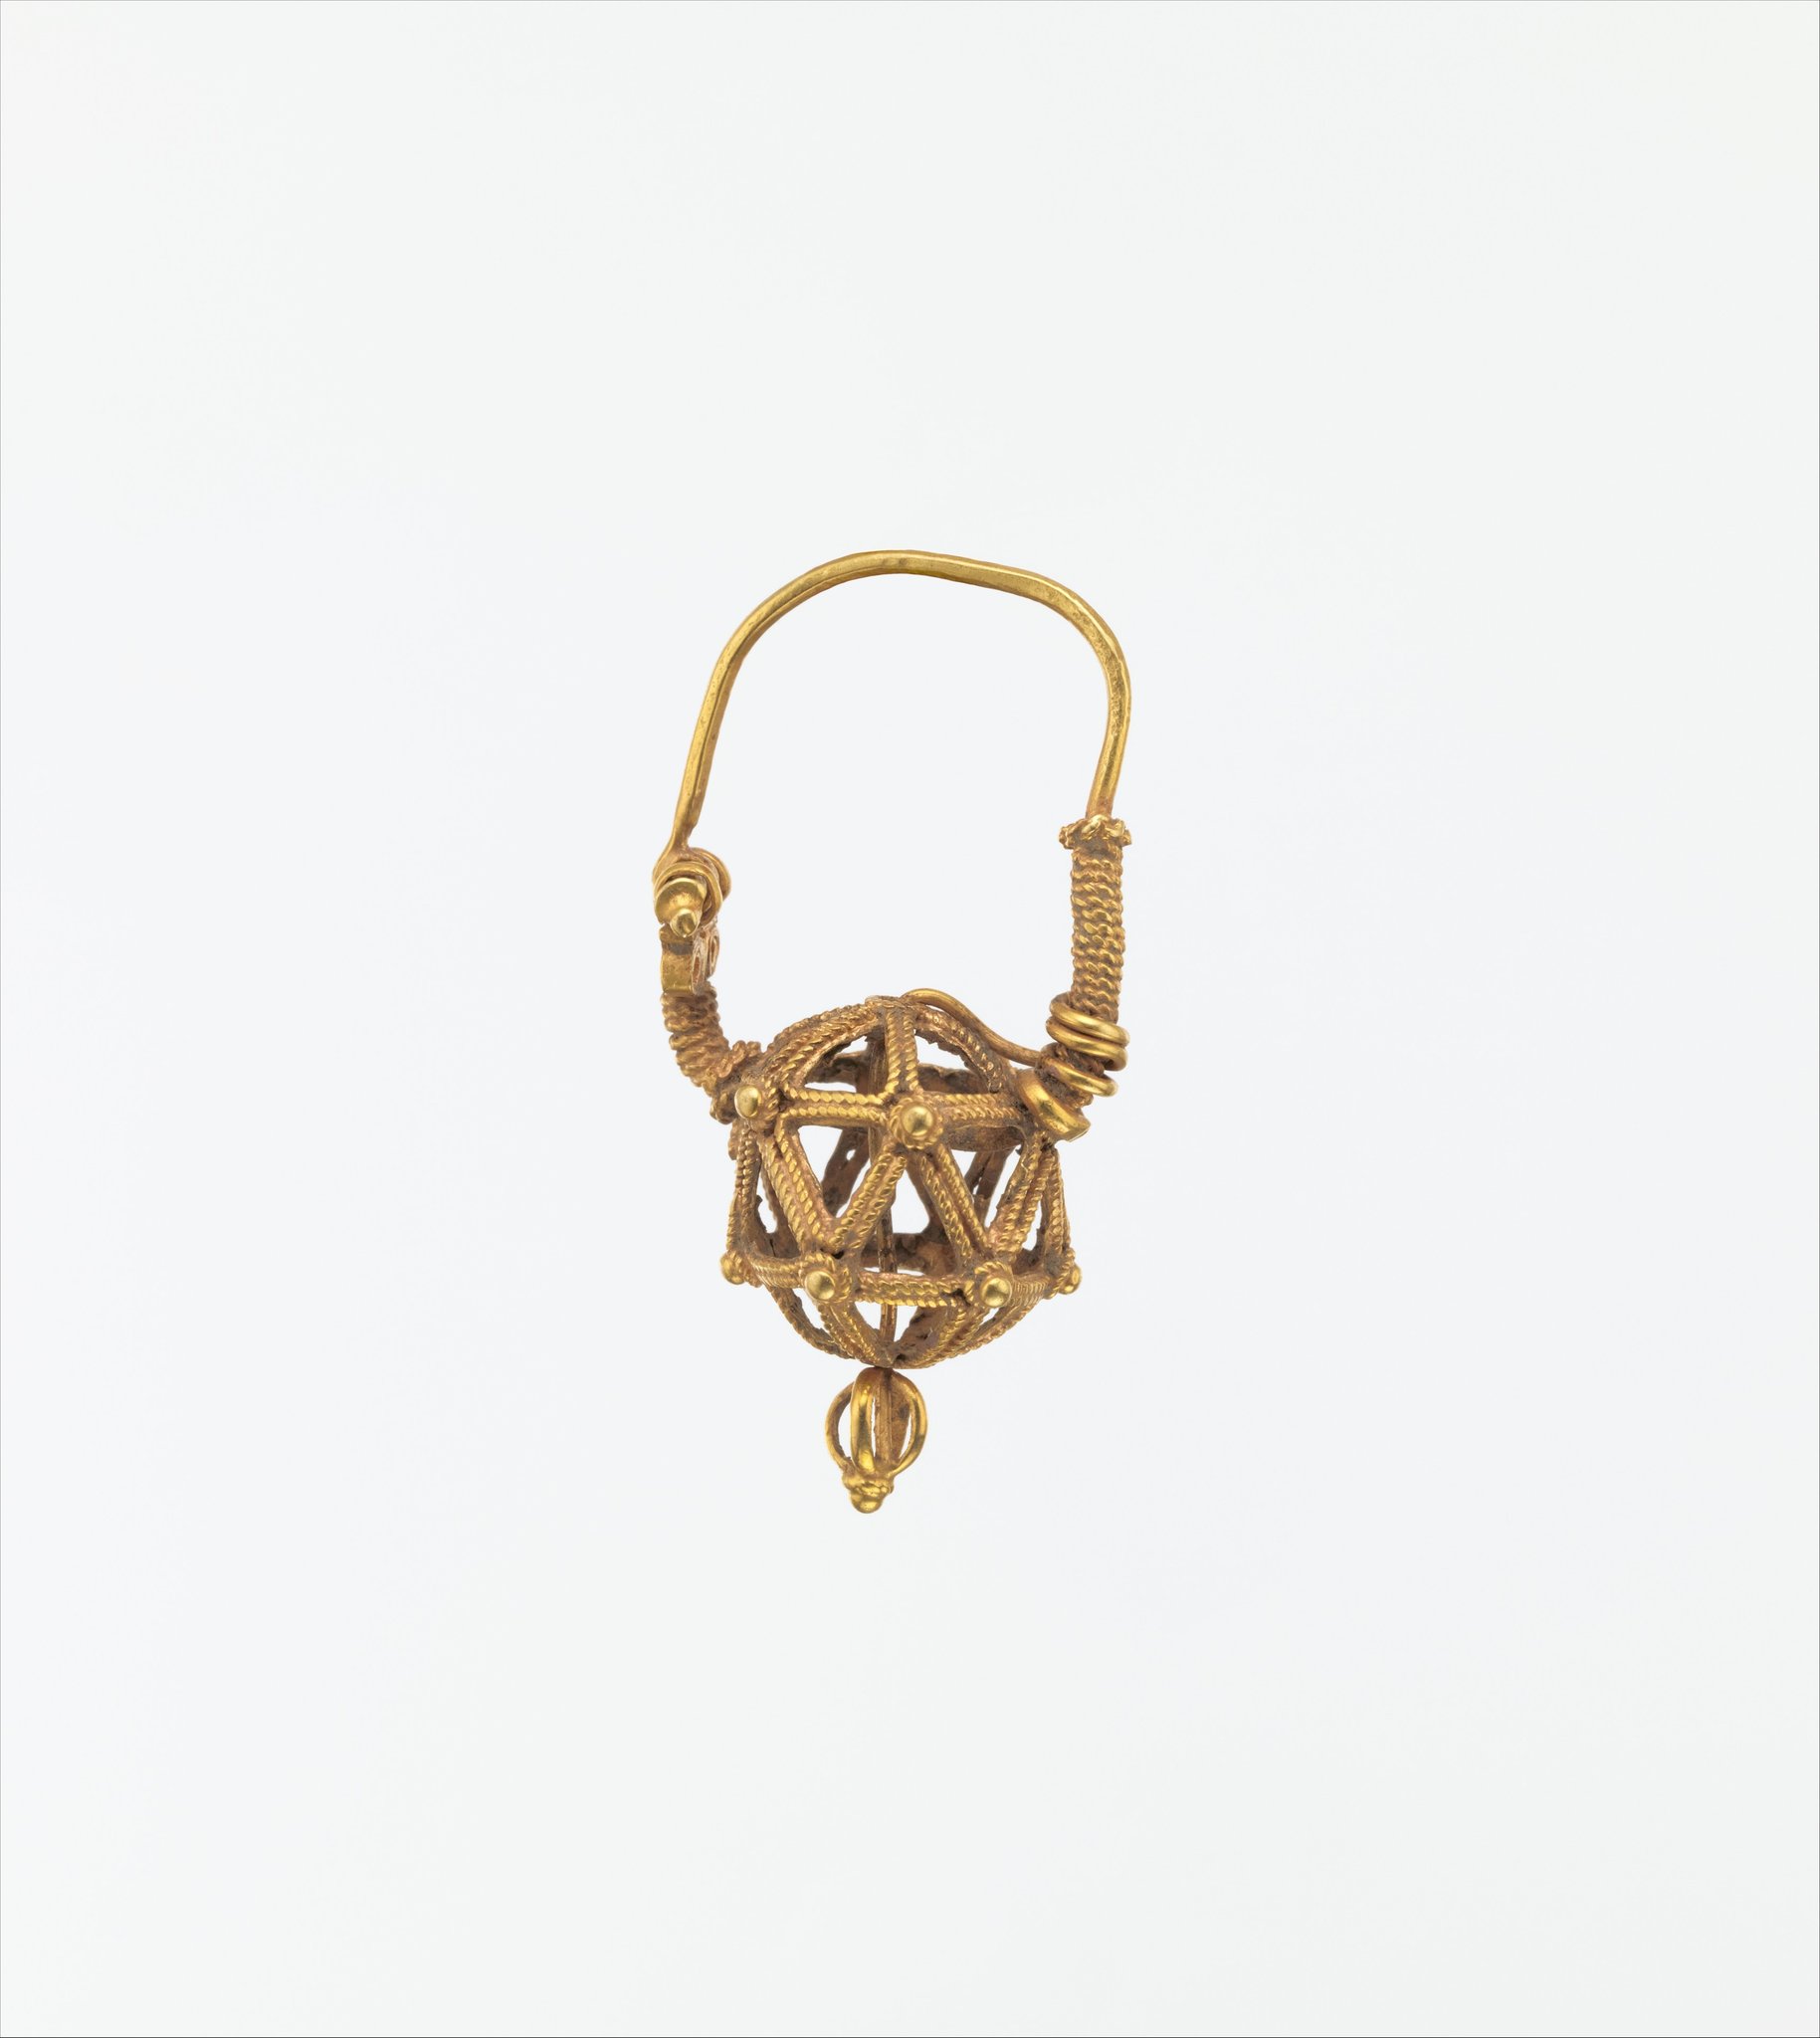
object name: earring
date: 1001-1050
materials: gold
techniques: filigree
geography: iran